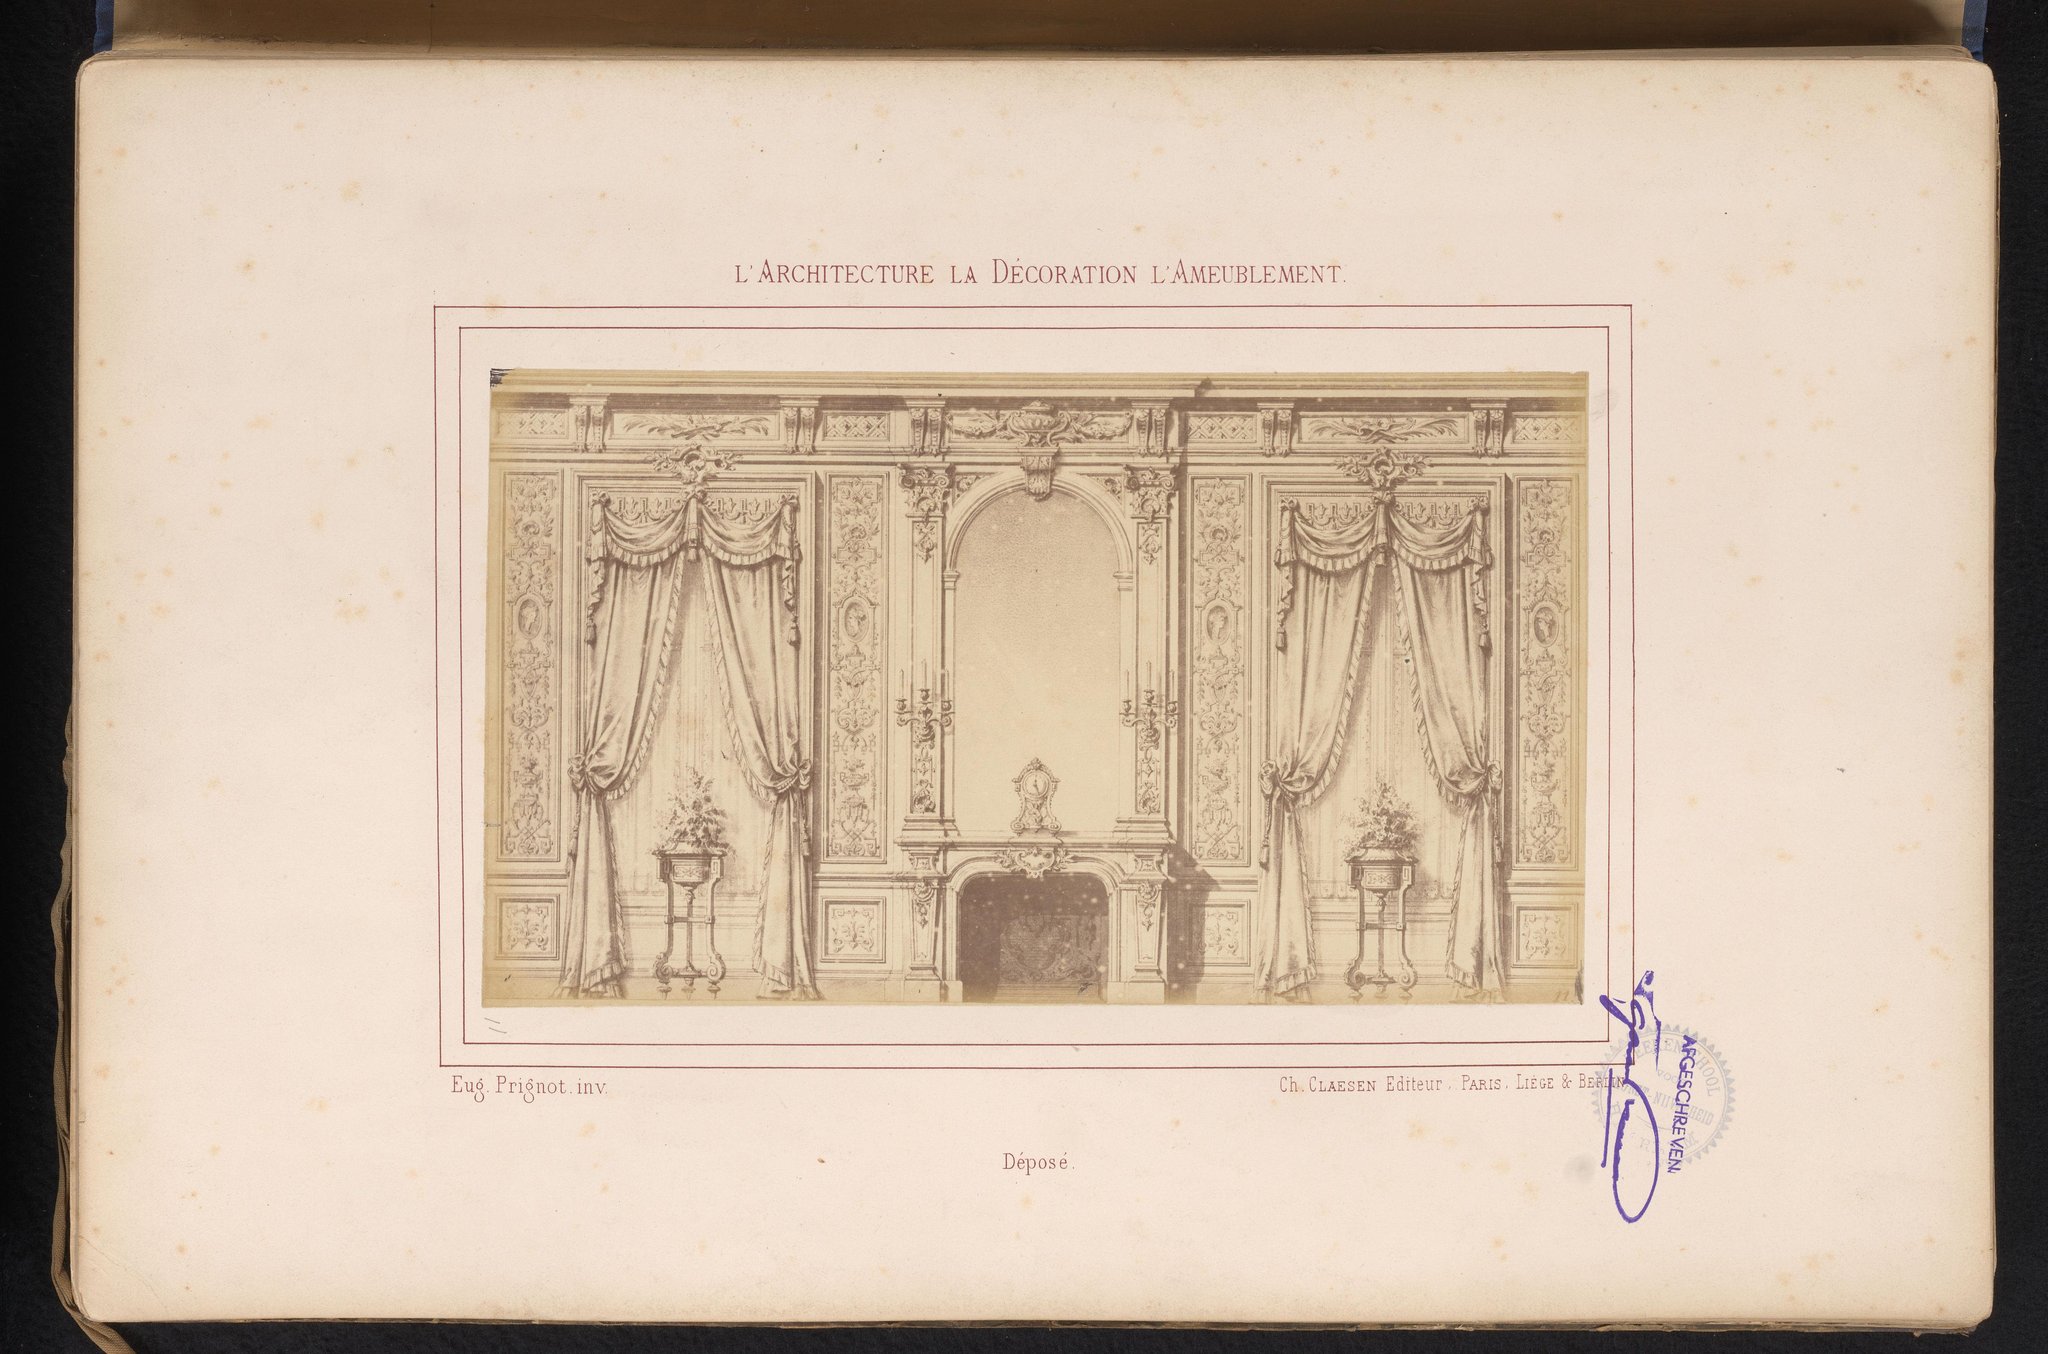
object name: photograph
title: Fotoreproductie van ontwerp voor een wandindeling met twee deuren en een haard met een spiegel naar Alexandre Eugène Prignot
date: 1873-1880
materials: cardboard, paper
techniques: albumen print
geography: liège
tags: mirror, open hearth, fire-place, door, wall-covering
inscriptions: inscription: ‘Déposé’, inscription: ‘Eug. Prignot. inv.’, stamp: ‘TEEKENSCHOOL/ VOOR/ KUNSTNIJVERHEID/ HAARLEM’, stamp: ‘AFGESCHREVEN/ [...]’, number: ‘11’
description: Deze foto maakt deel uit van een omslag met 61 foto's op 61 bladen.